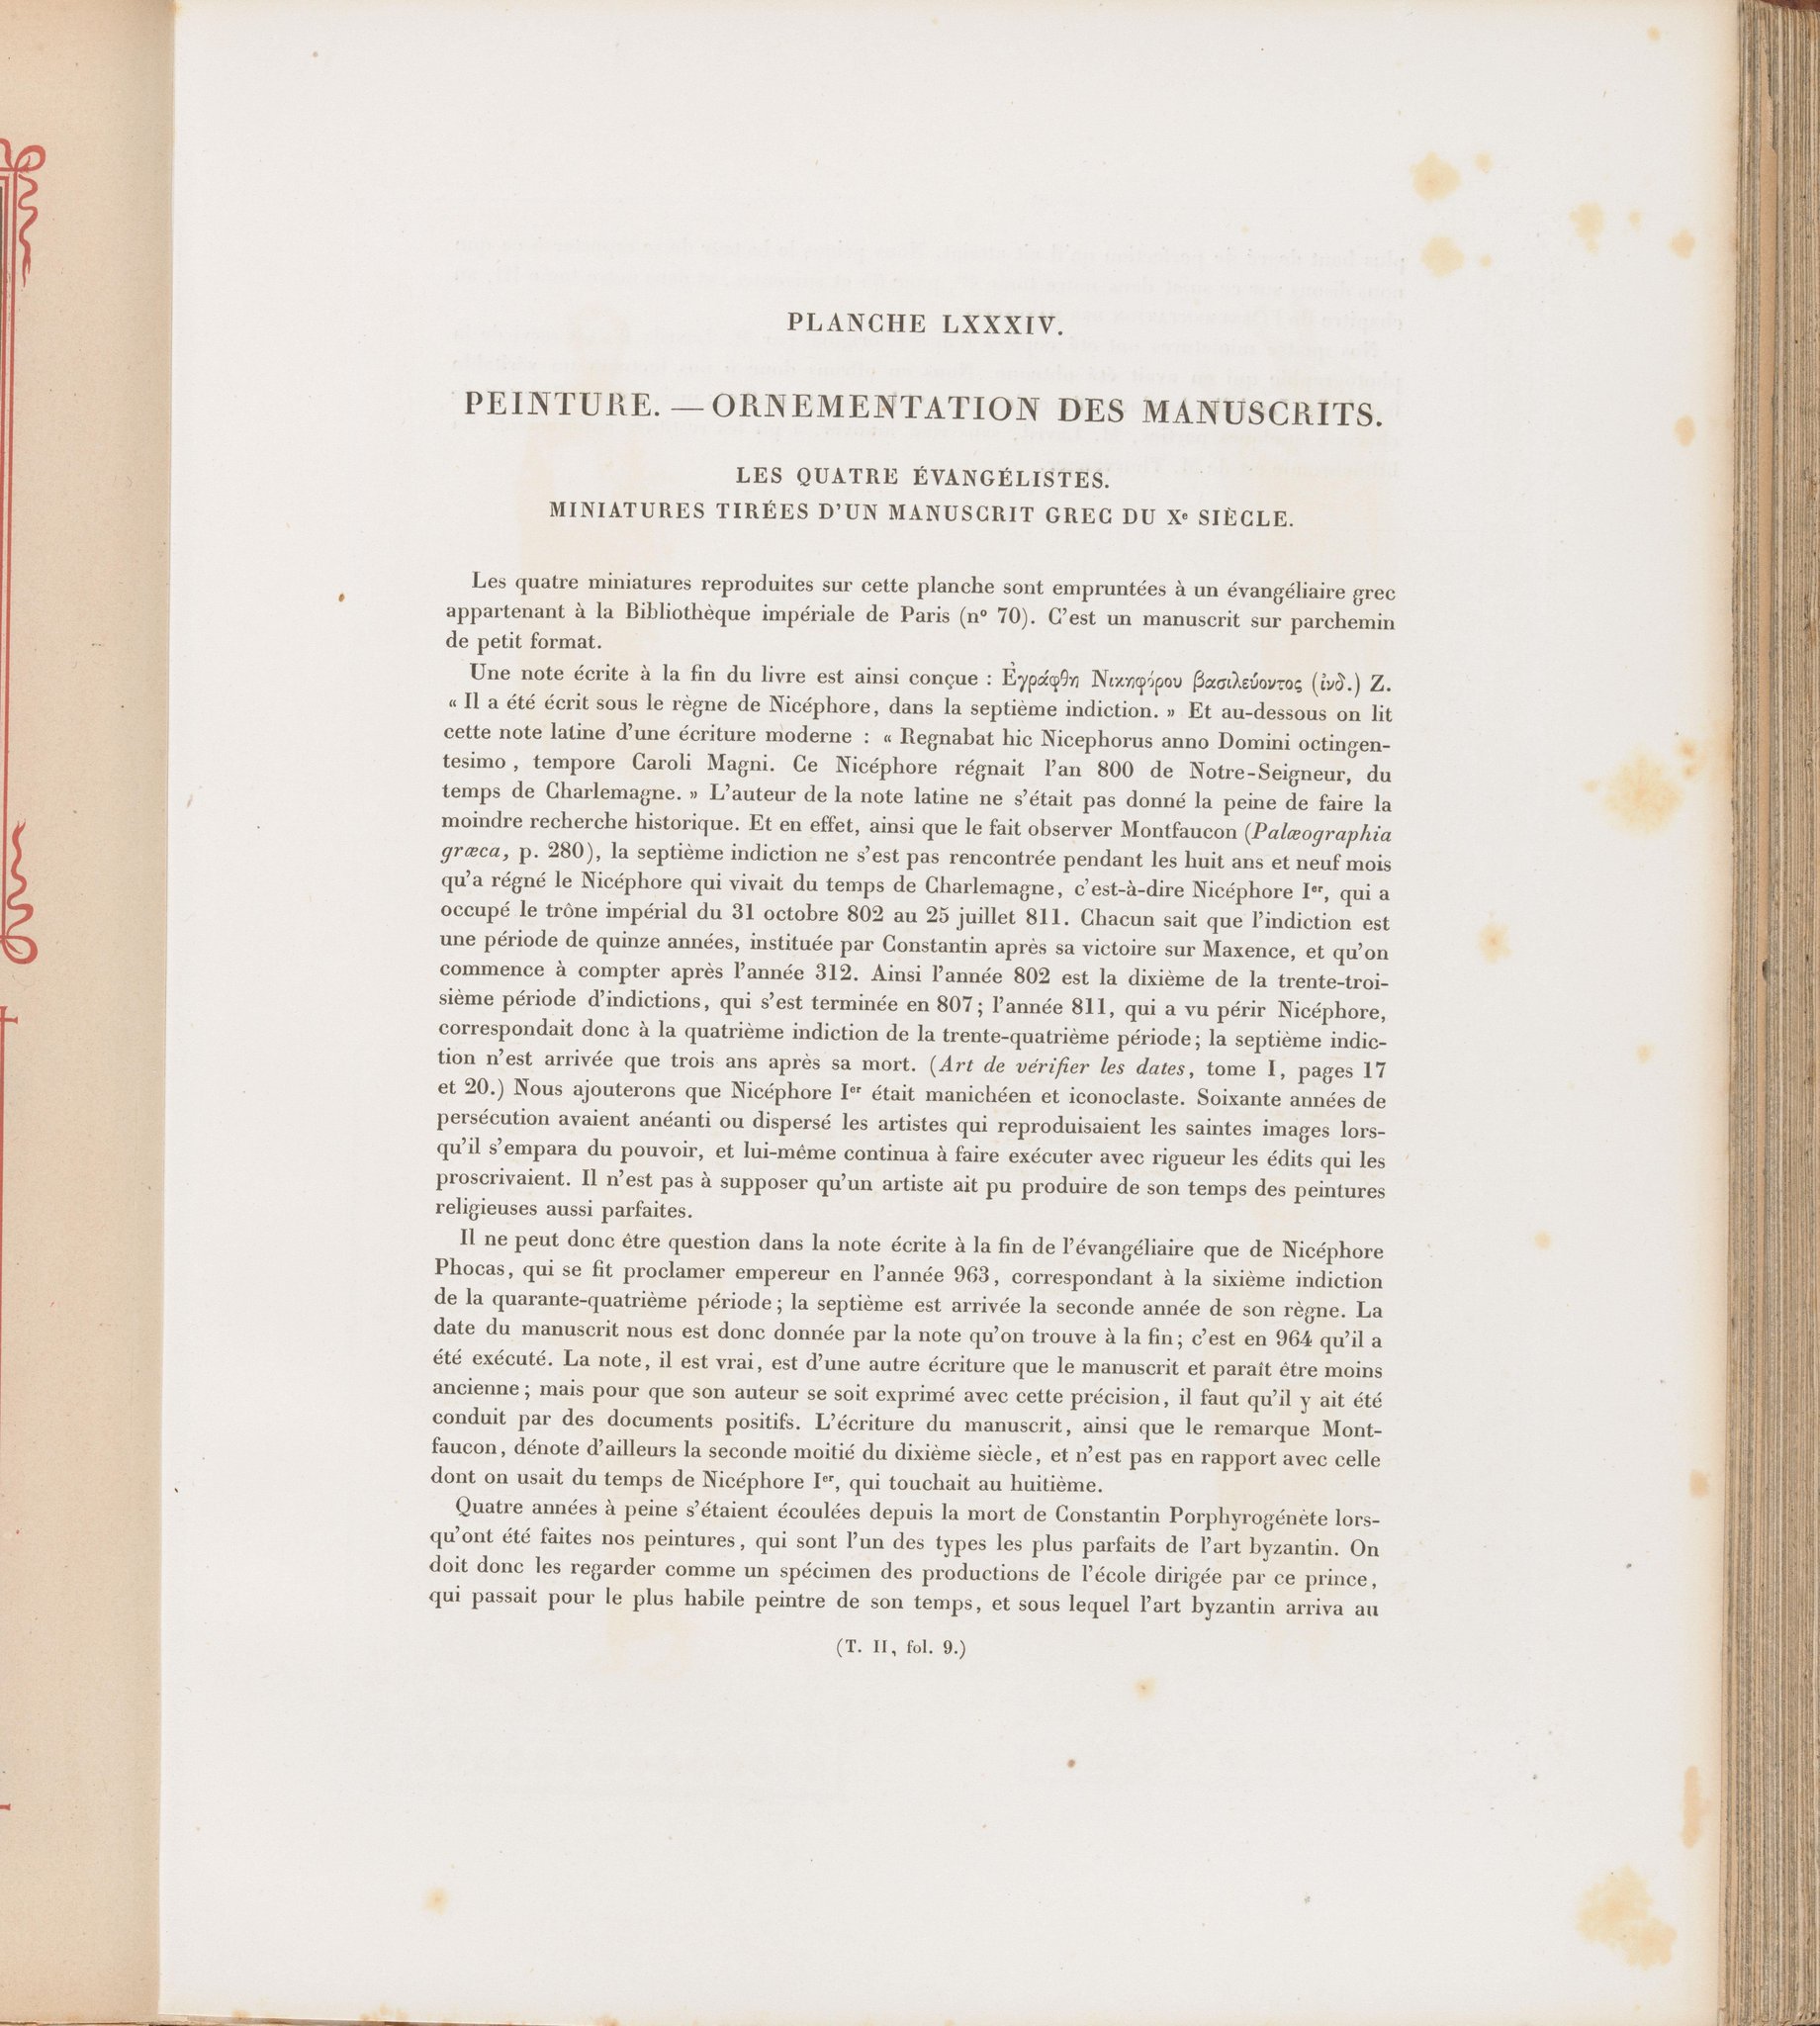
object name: print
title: Les quatre evangélistes, miniatures tirées d'un ms. Grec du Xe Siècle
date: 1859-1864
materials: paper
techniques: chromolithography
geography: paris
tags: the four evangelists ~ other themes, painting (including book-illumination, miniature-painting)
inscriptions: name: ‘Lavril del./ Thurvanger Lith’